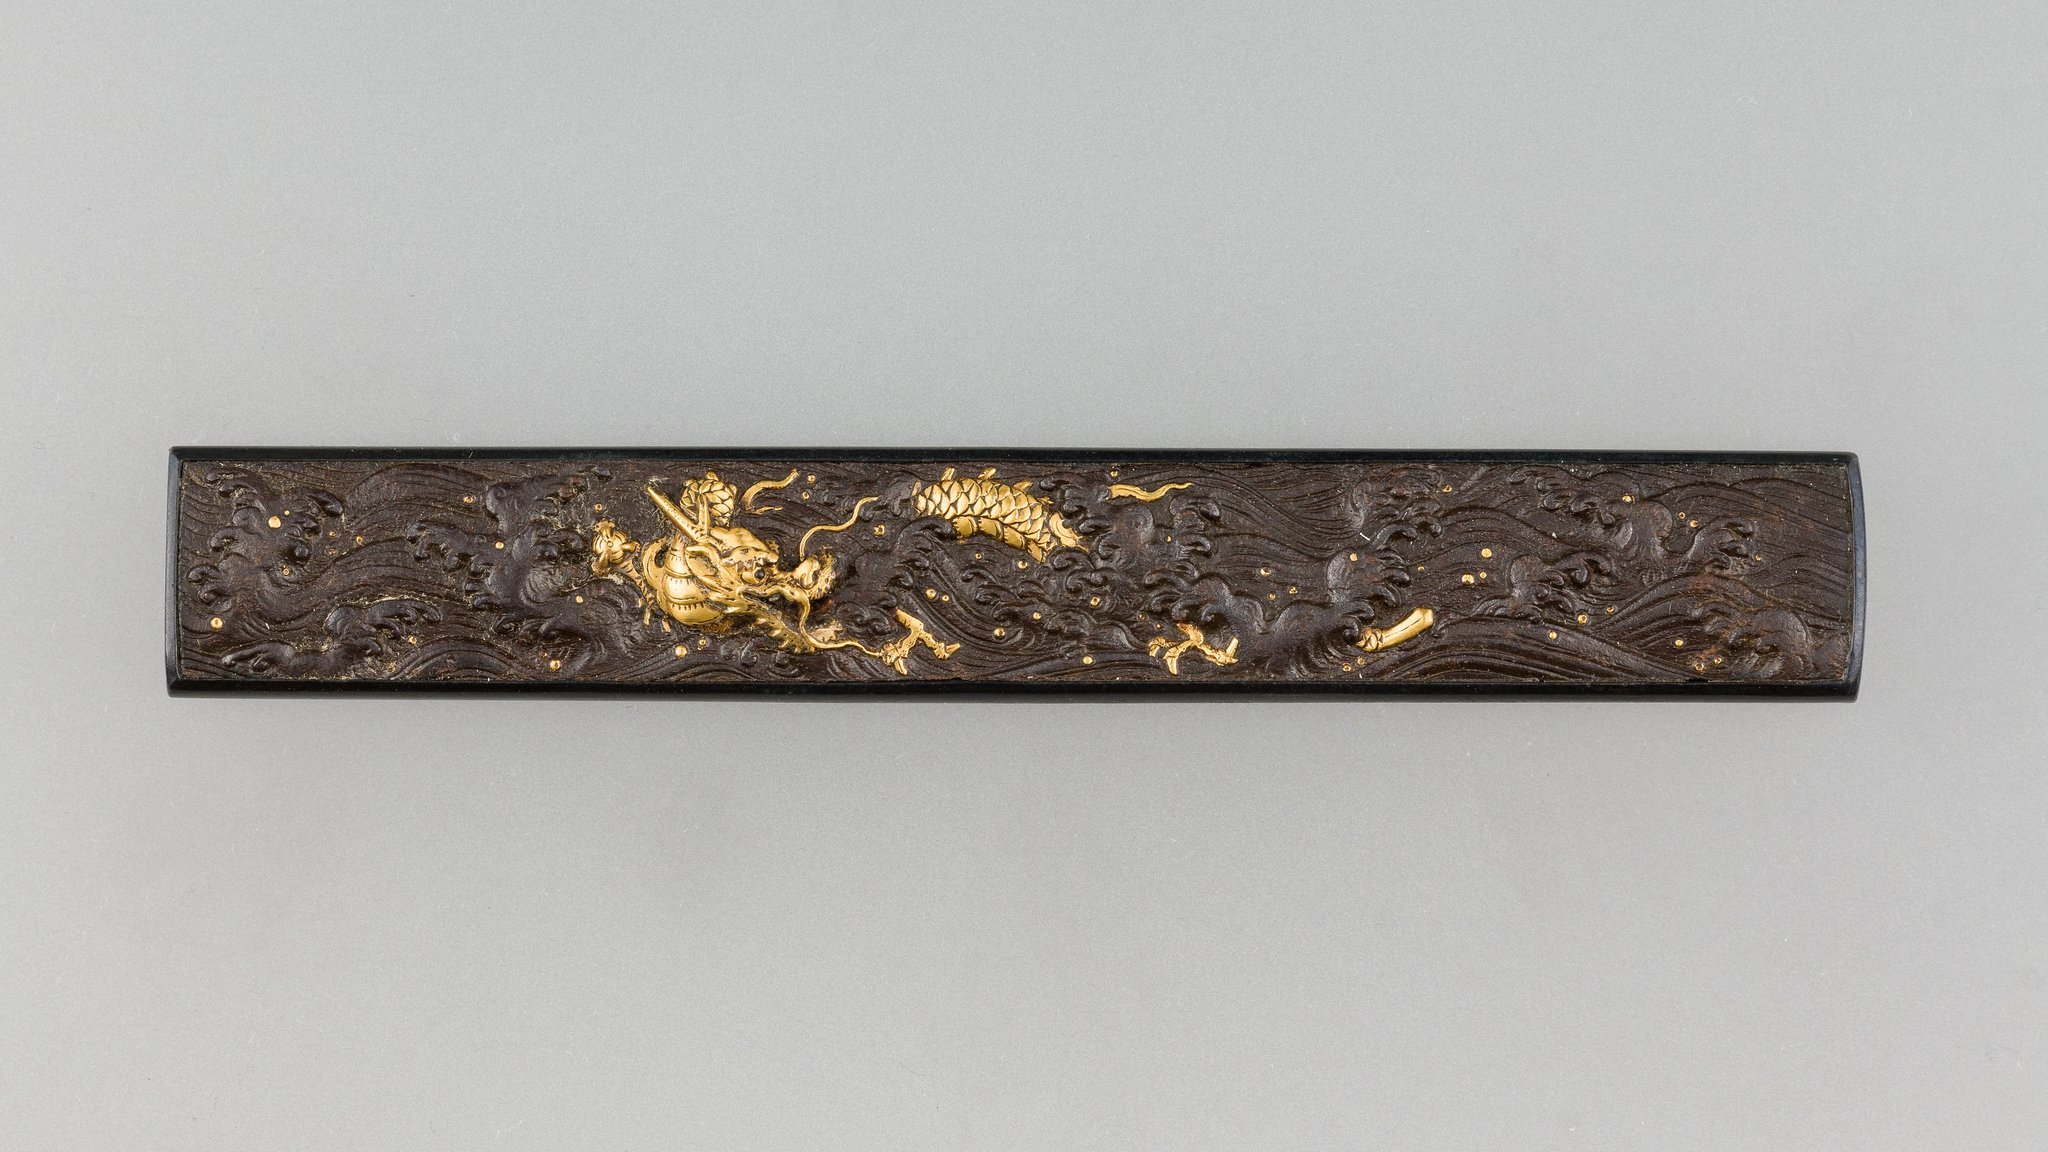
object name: knife handle kozuka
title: Knife Handle (Kozuka)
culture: japanese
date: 1701-1800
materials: gold alloy, silver alloy, gold, iron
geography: japan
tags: dragons